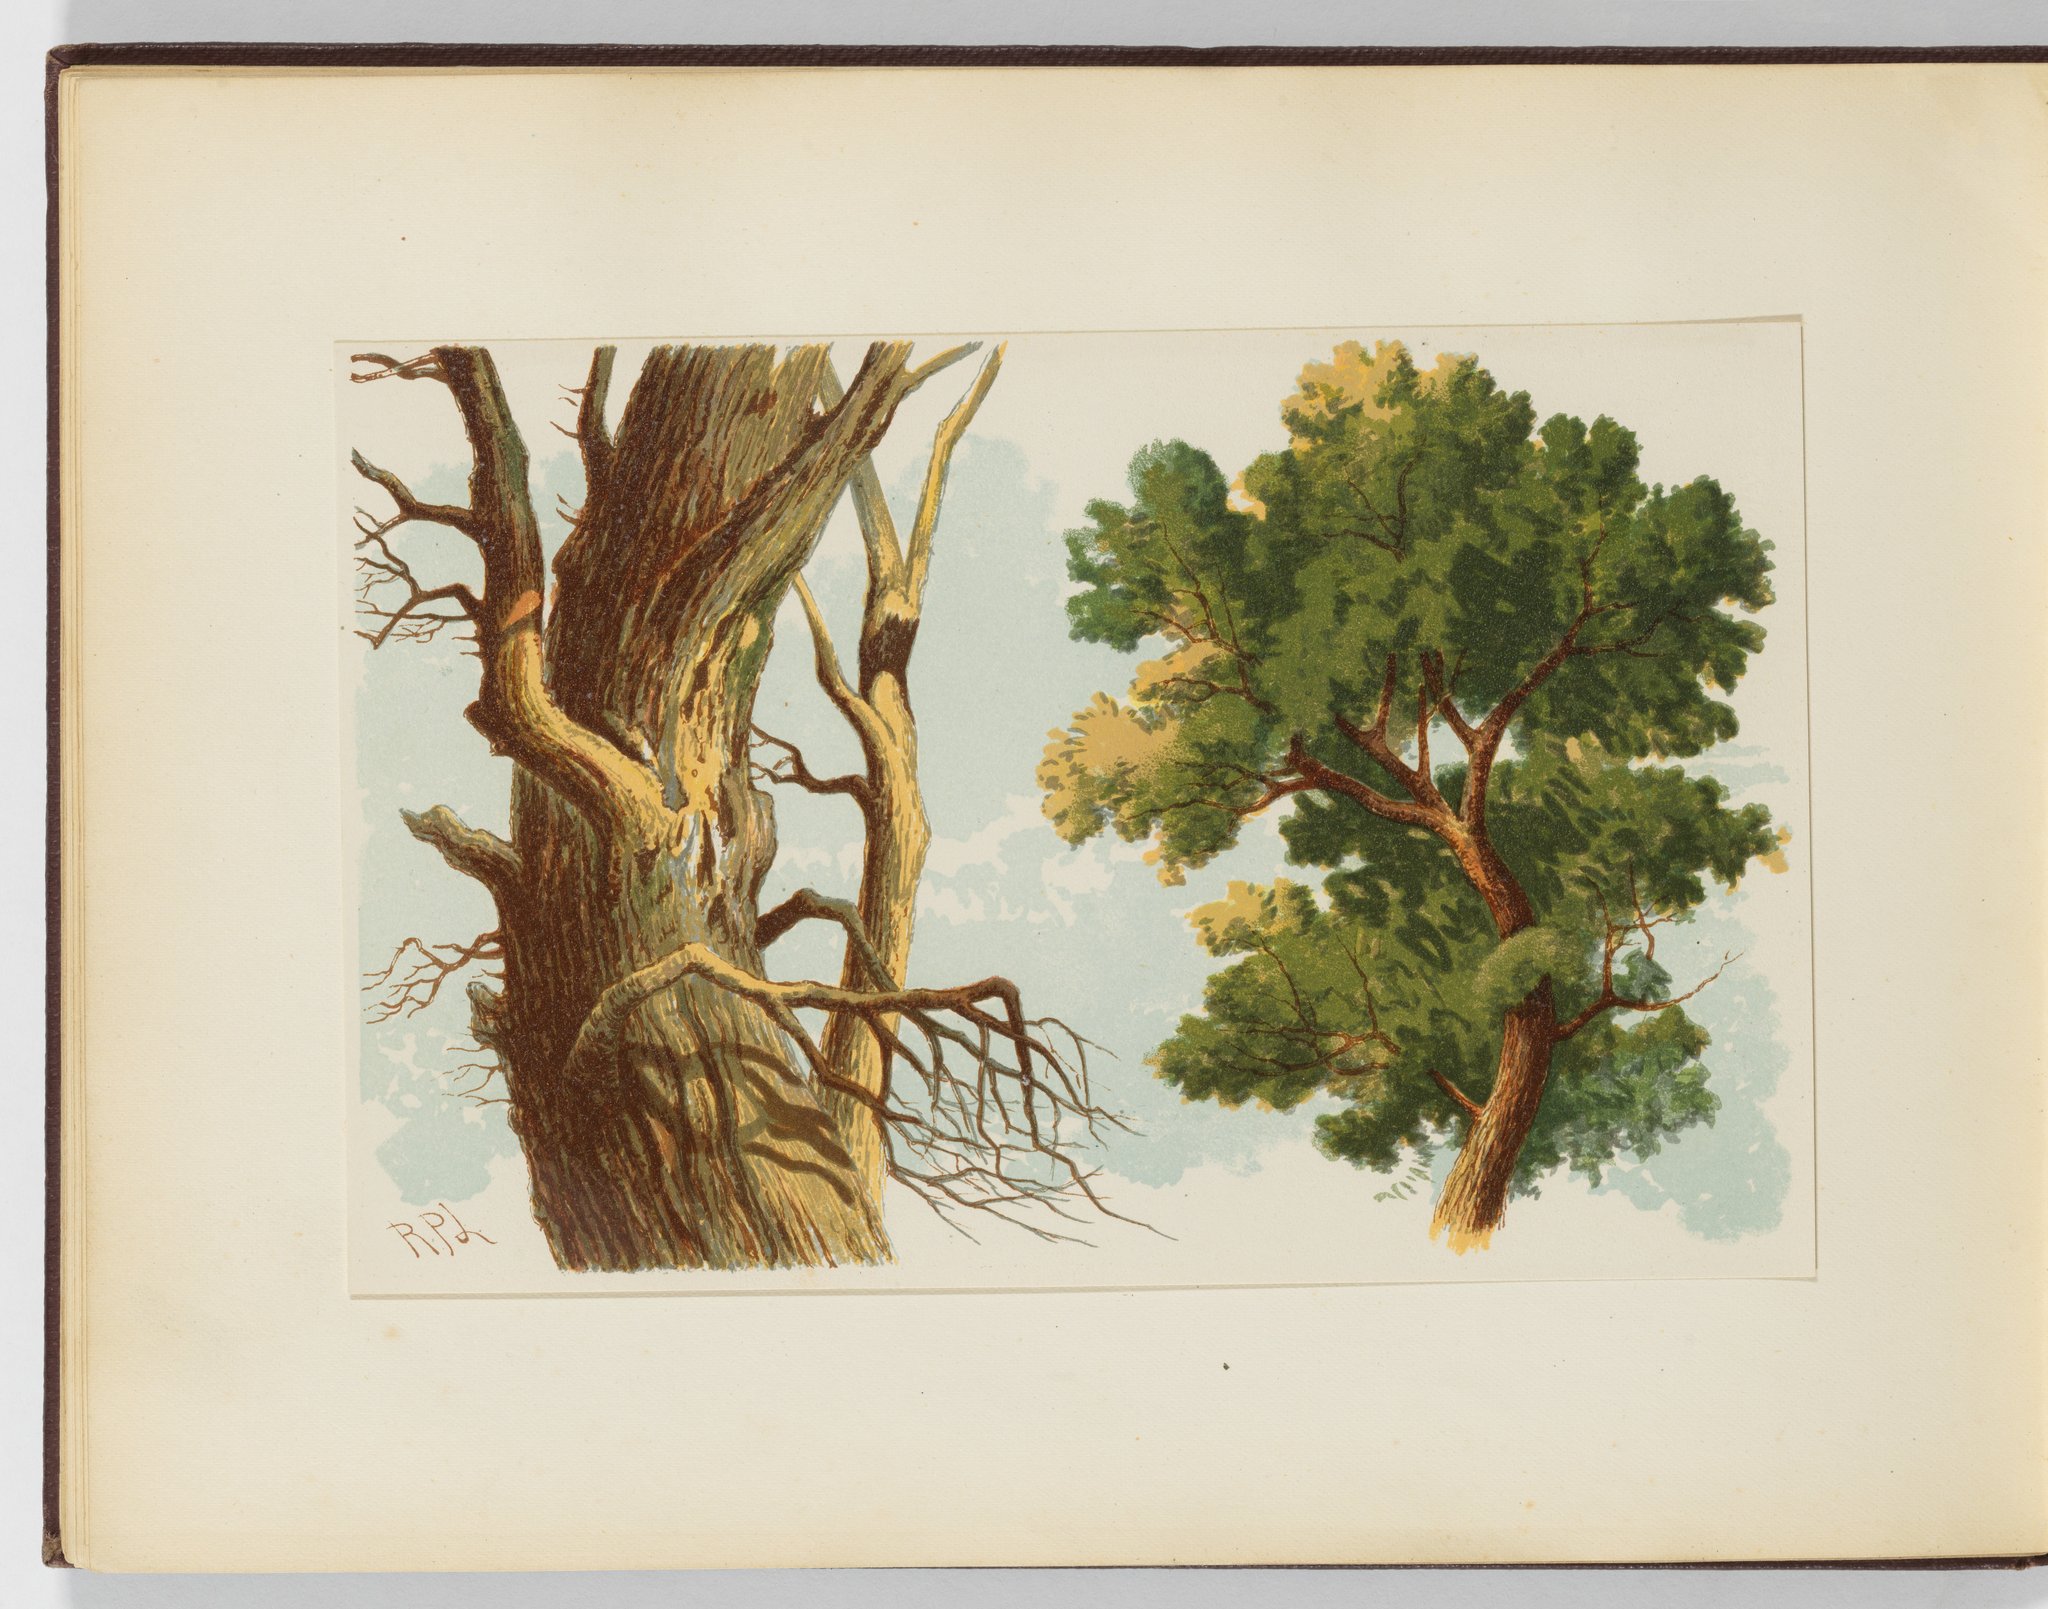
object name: book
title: A Course of Water-Colour Painting with Twenty-Four Coloured Plates from Designs by R. P. Leitch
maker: richard principal leitch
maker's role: author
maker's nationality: british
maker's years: 1826-1882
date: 1886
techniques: lithograph